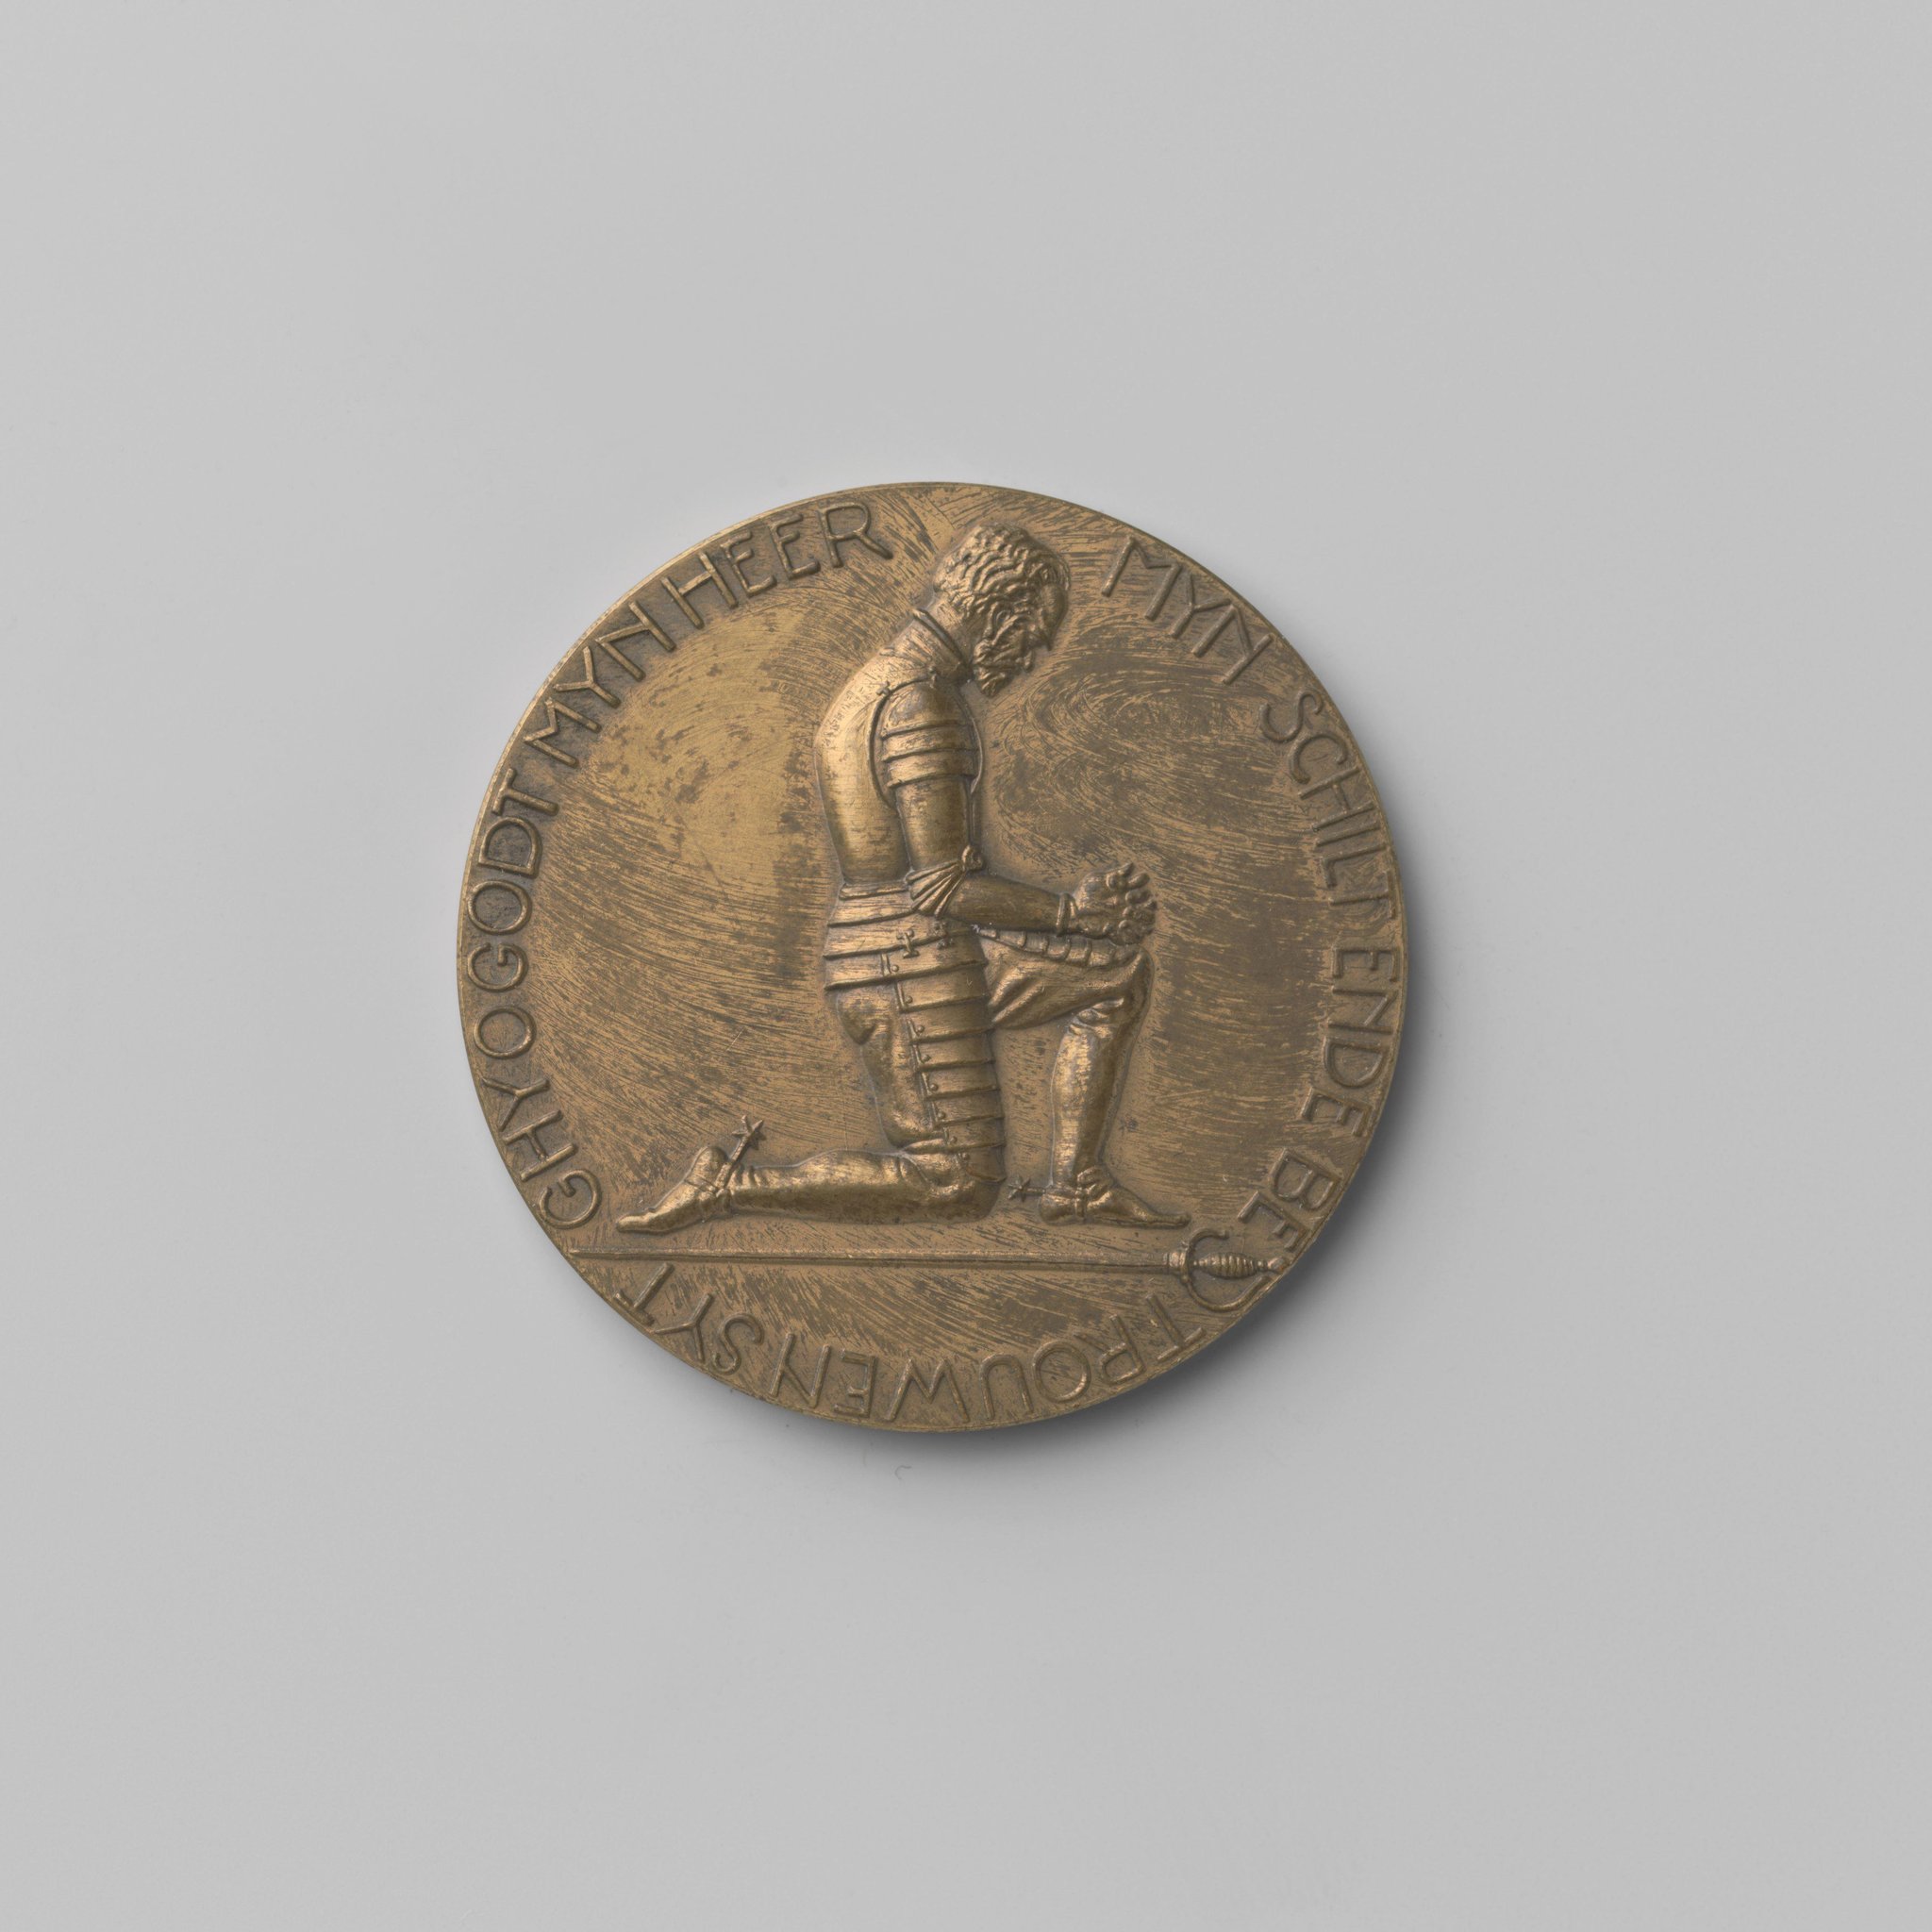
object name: history medal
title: Vierhonderdjarige herdenking van de geboorte van Willem van Oranje in 1933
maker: oswald wenckebach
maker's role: draughtsman, print maker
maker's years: 1895-1962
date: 1933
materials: bronze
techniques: striking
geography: utrecht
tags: delft, william i (prince of orange)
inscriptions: factory mark: ‘mercuriusstaf’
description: Bronzen penning, op de voorzijde Willem knielend naar rechts met omschrift, op de keerzijde een vogel op een nest in de golven, met omschrift.